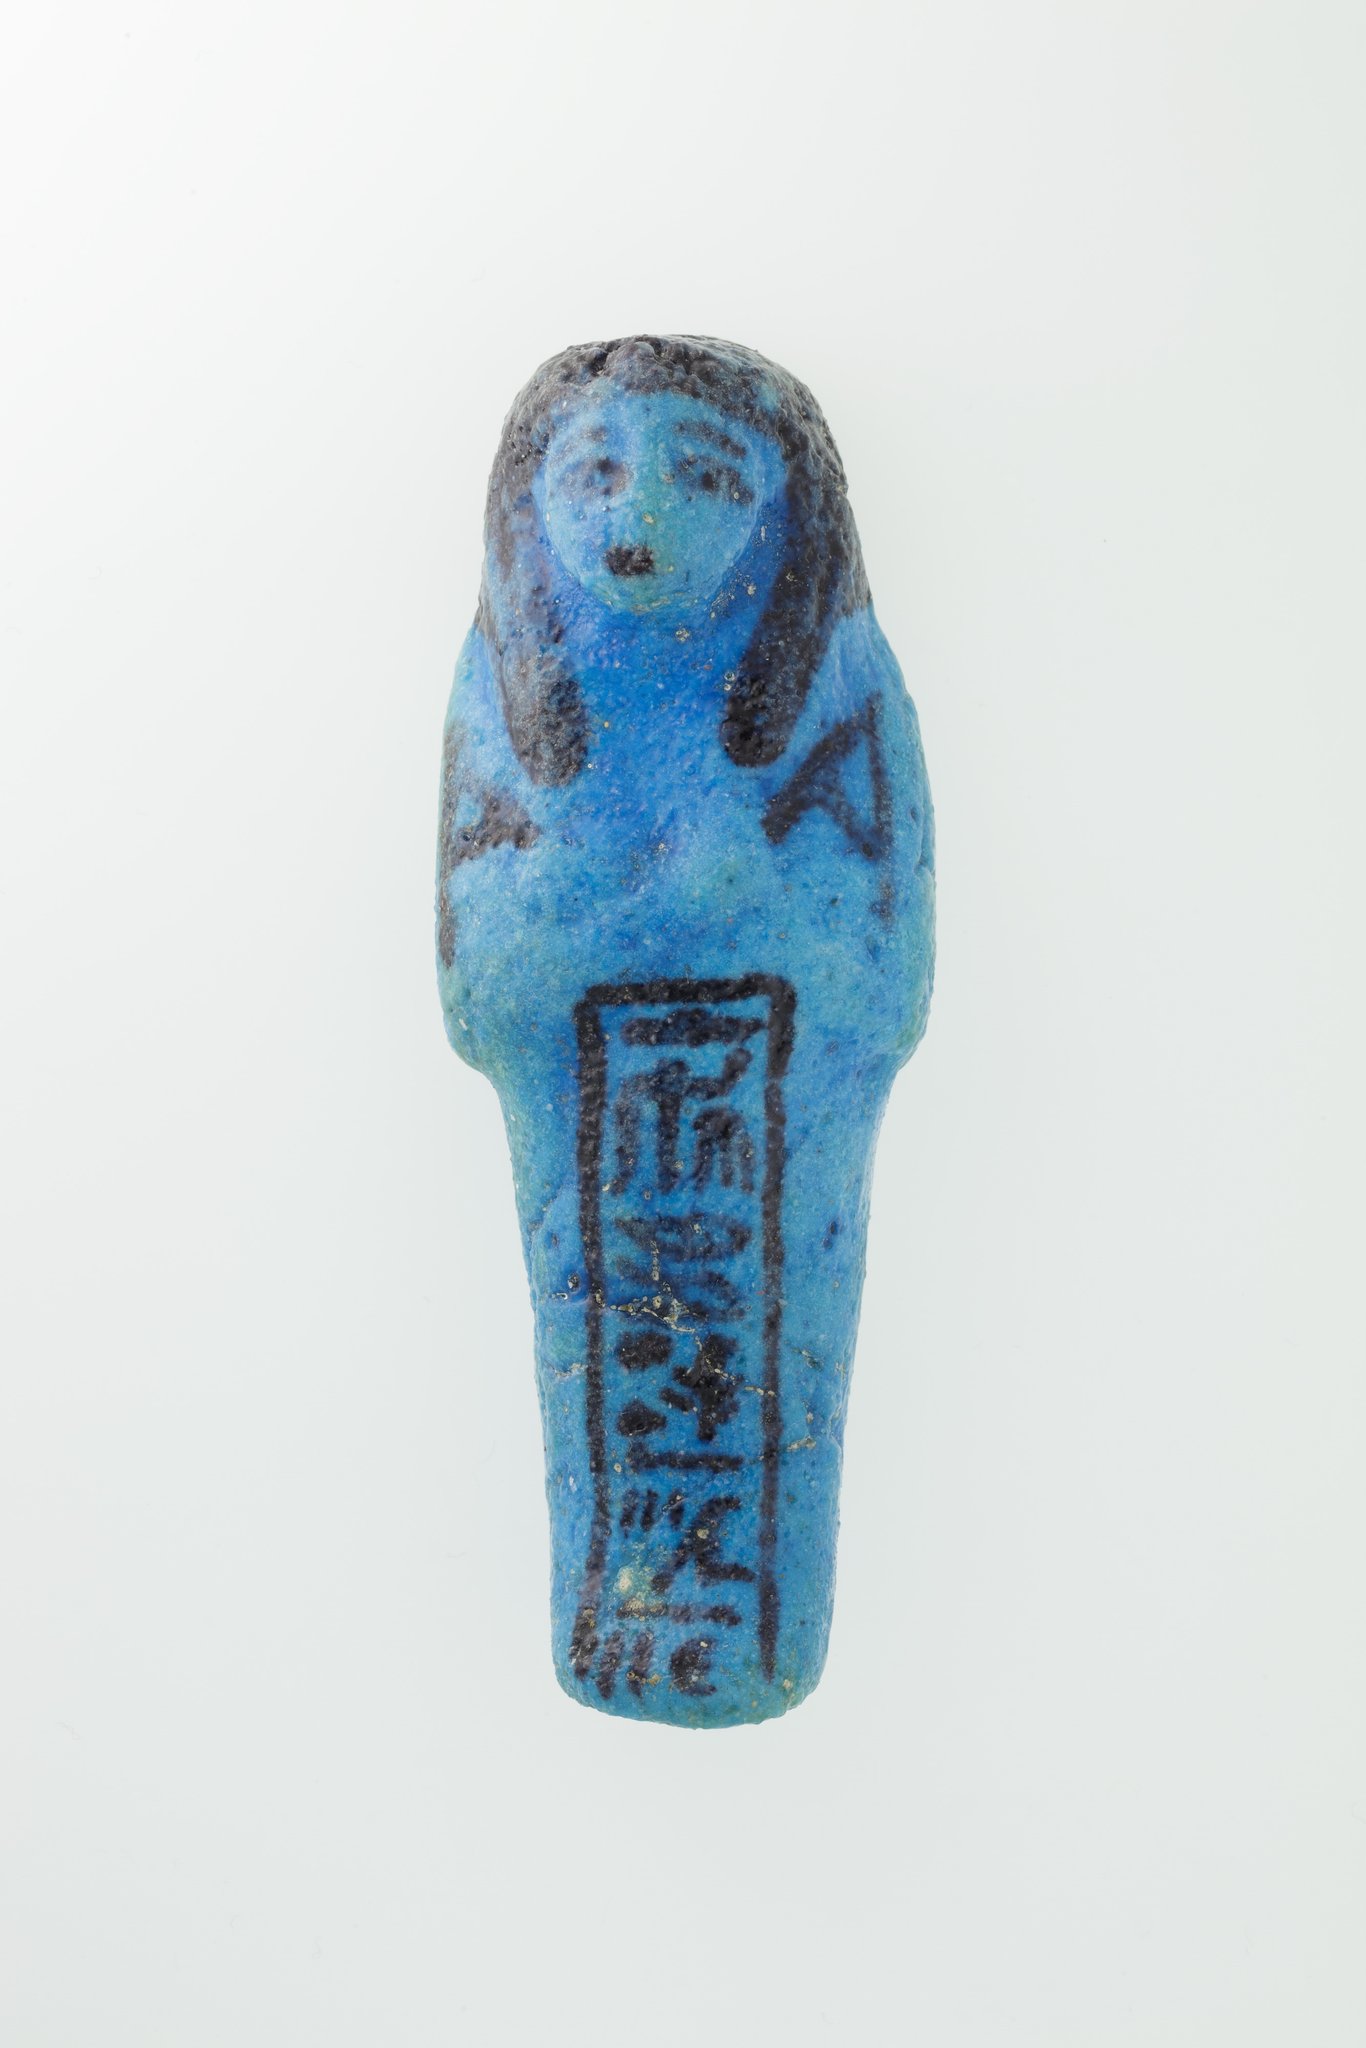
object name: shabti, worker, nauny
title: Worker Shabti of Nauny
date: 1050 BCE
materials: faience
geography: egypt